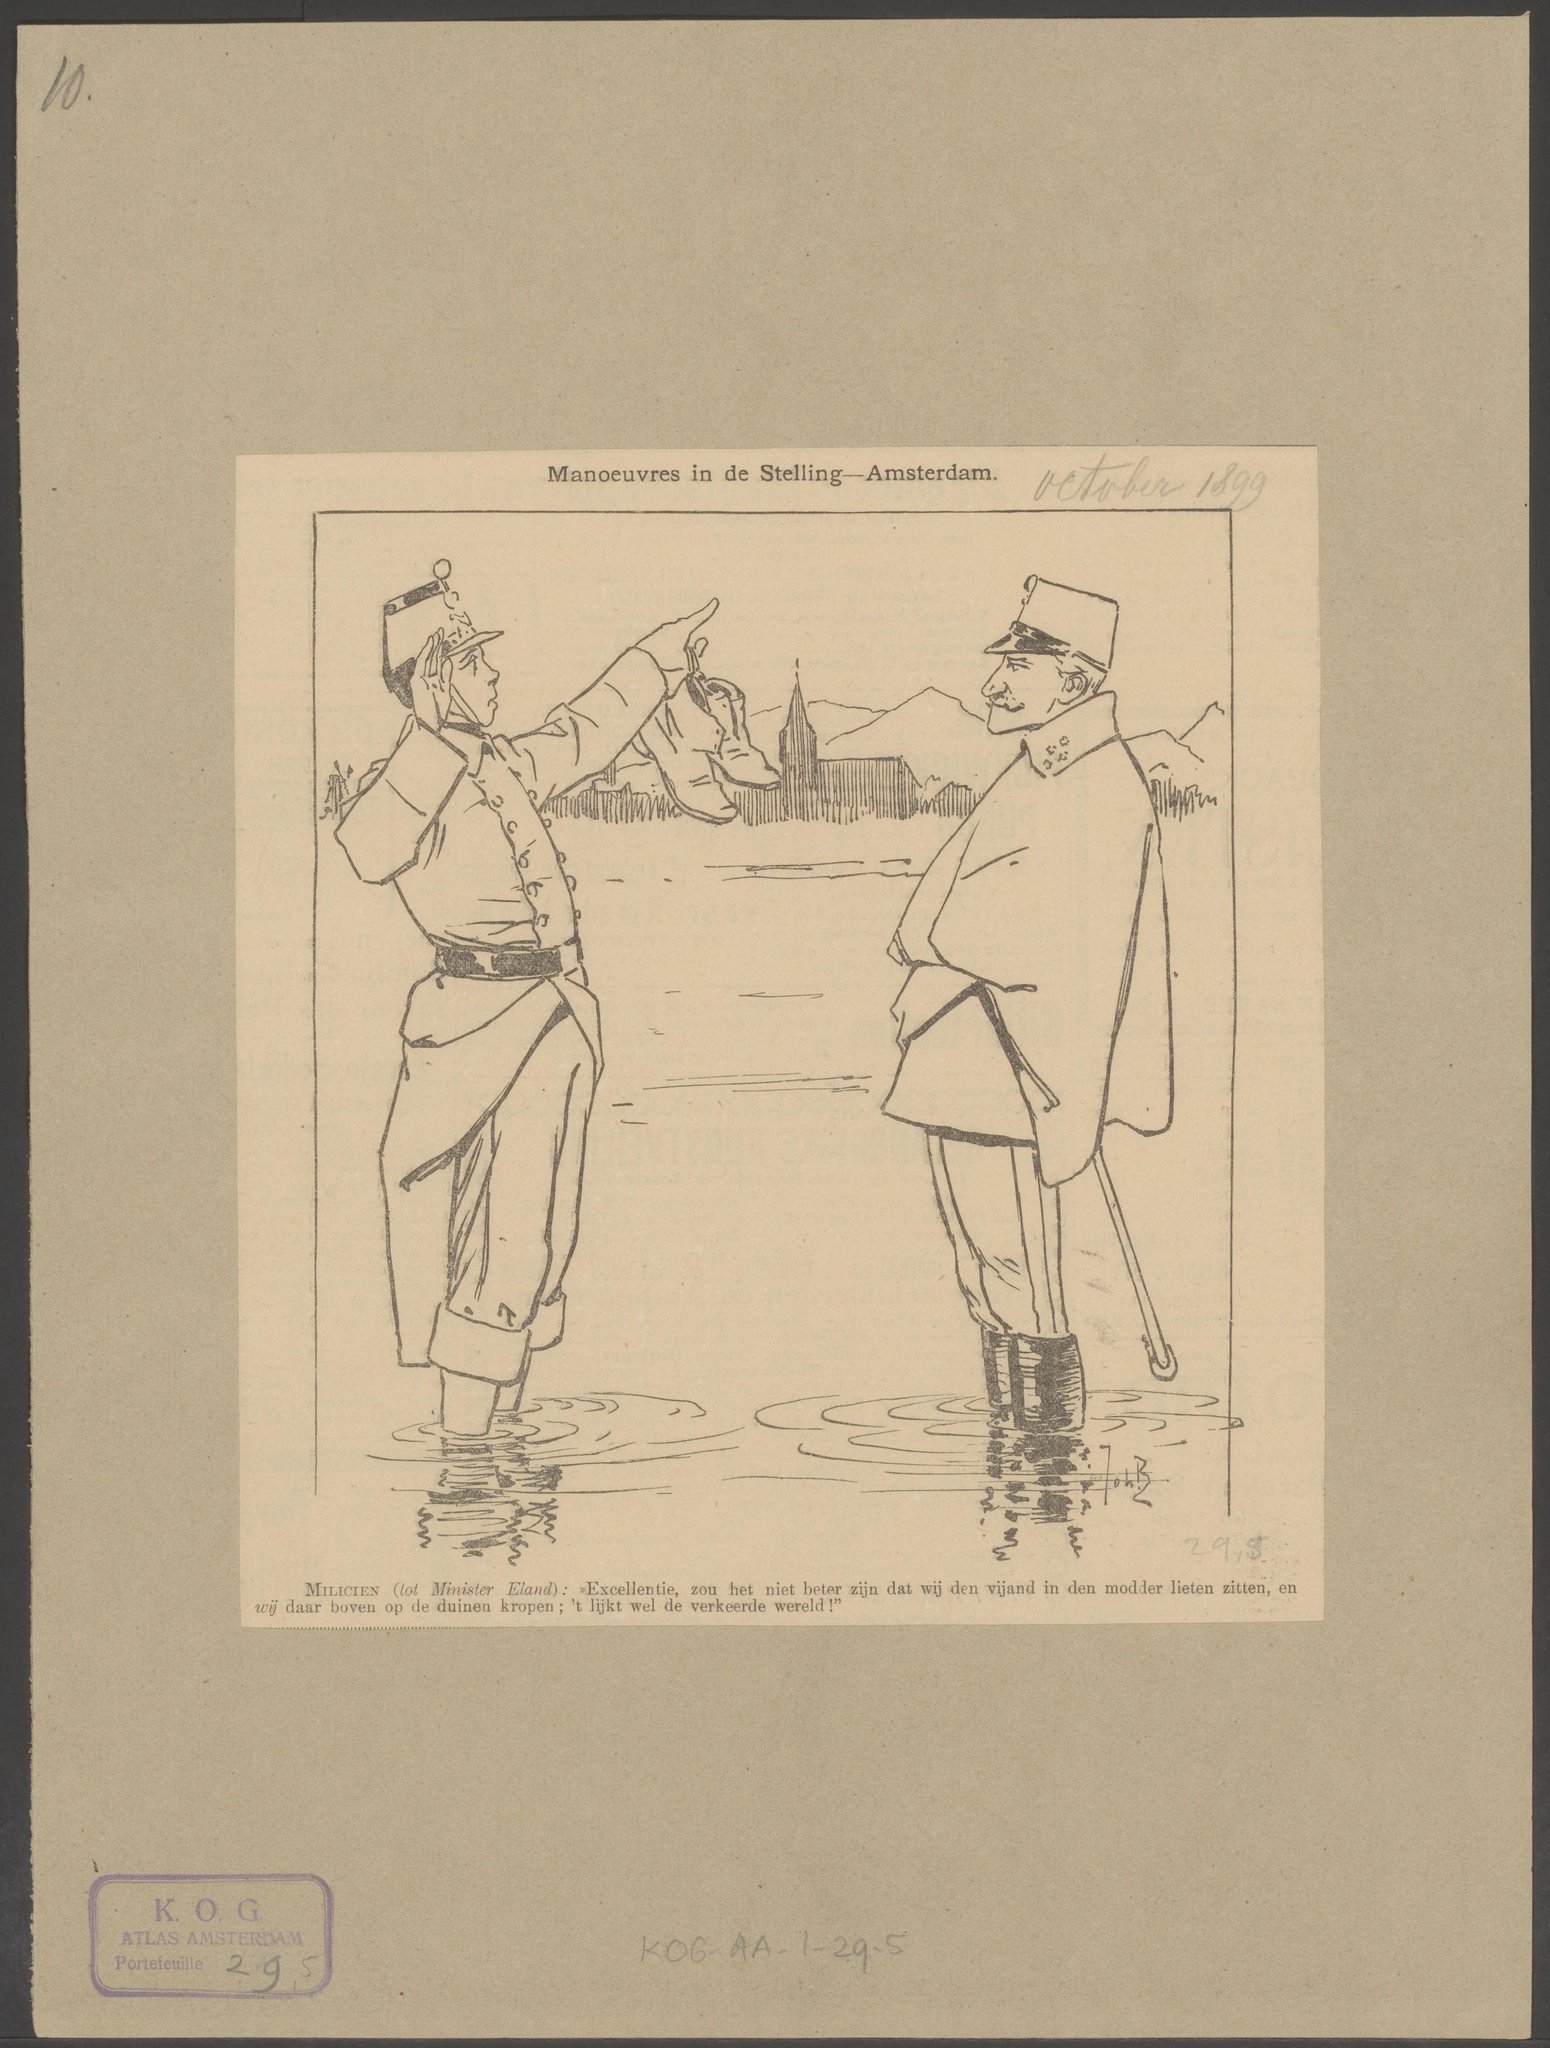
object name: photomechanical print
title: Manoeuvres in de Stelling-Amsterdam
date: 1899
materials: paper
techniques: letterpress printing, line block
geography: amsterdam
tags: klundert, utrecht, politician, water meadows under water, fortifications, military engineering, political caricatures and satires, amsterdam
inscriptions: collector's mark: Lugt 1641b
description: Prent uit: De Amsterdammer 23 (1899), nr. 1163, 8 oktober 1899, p. 9.